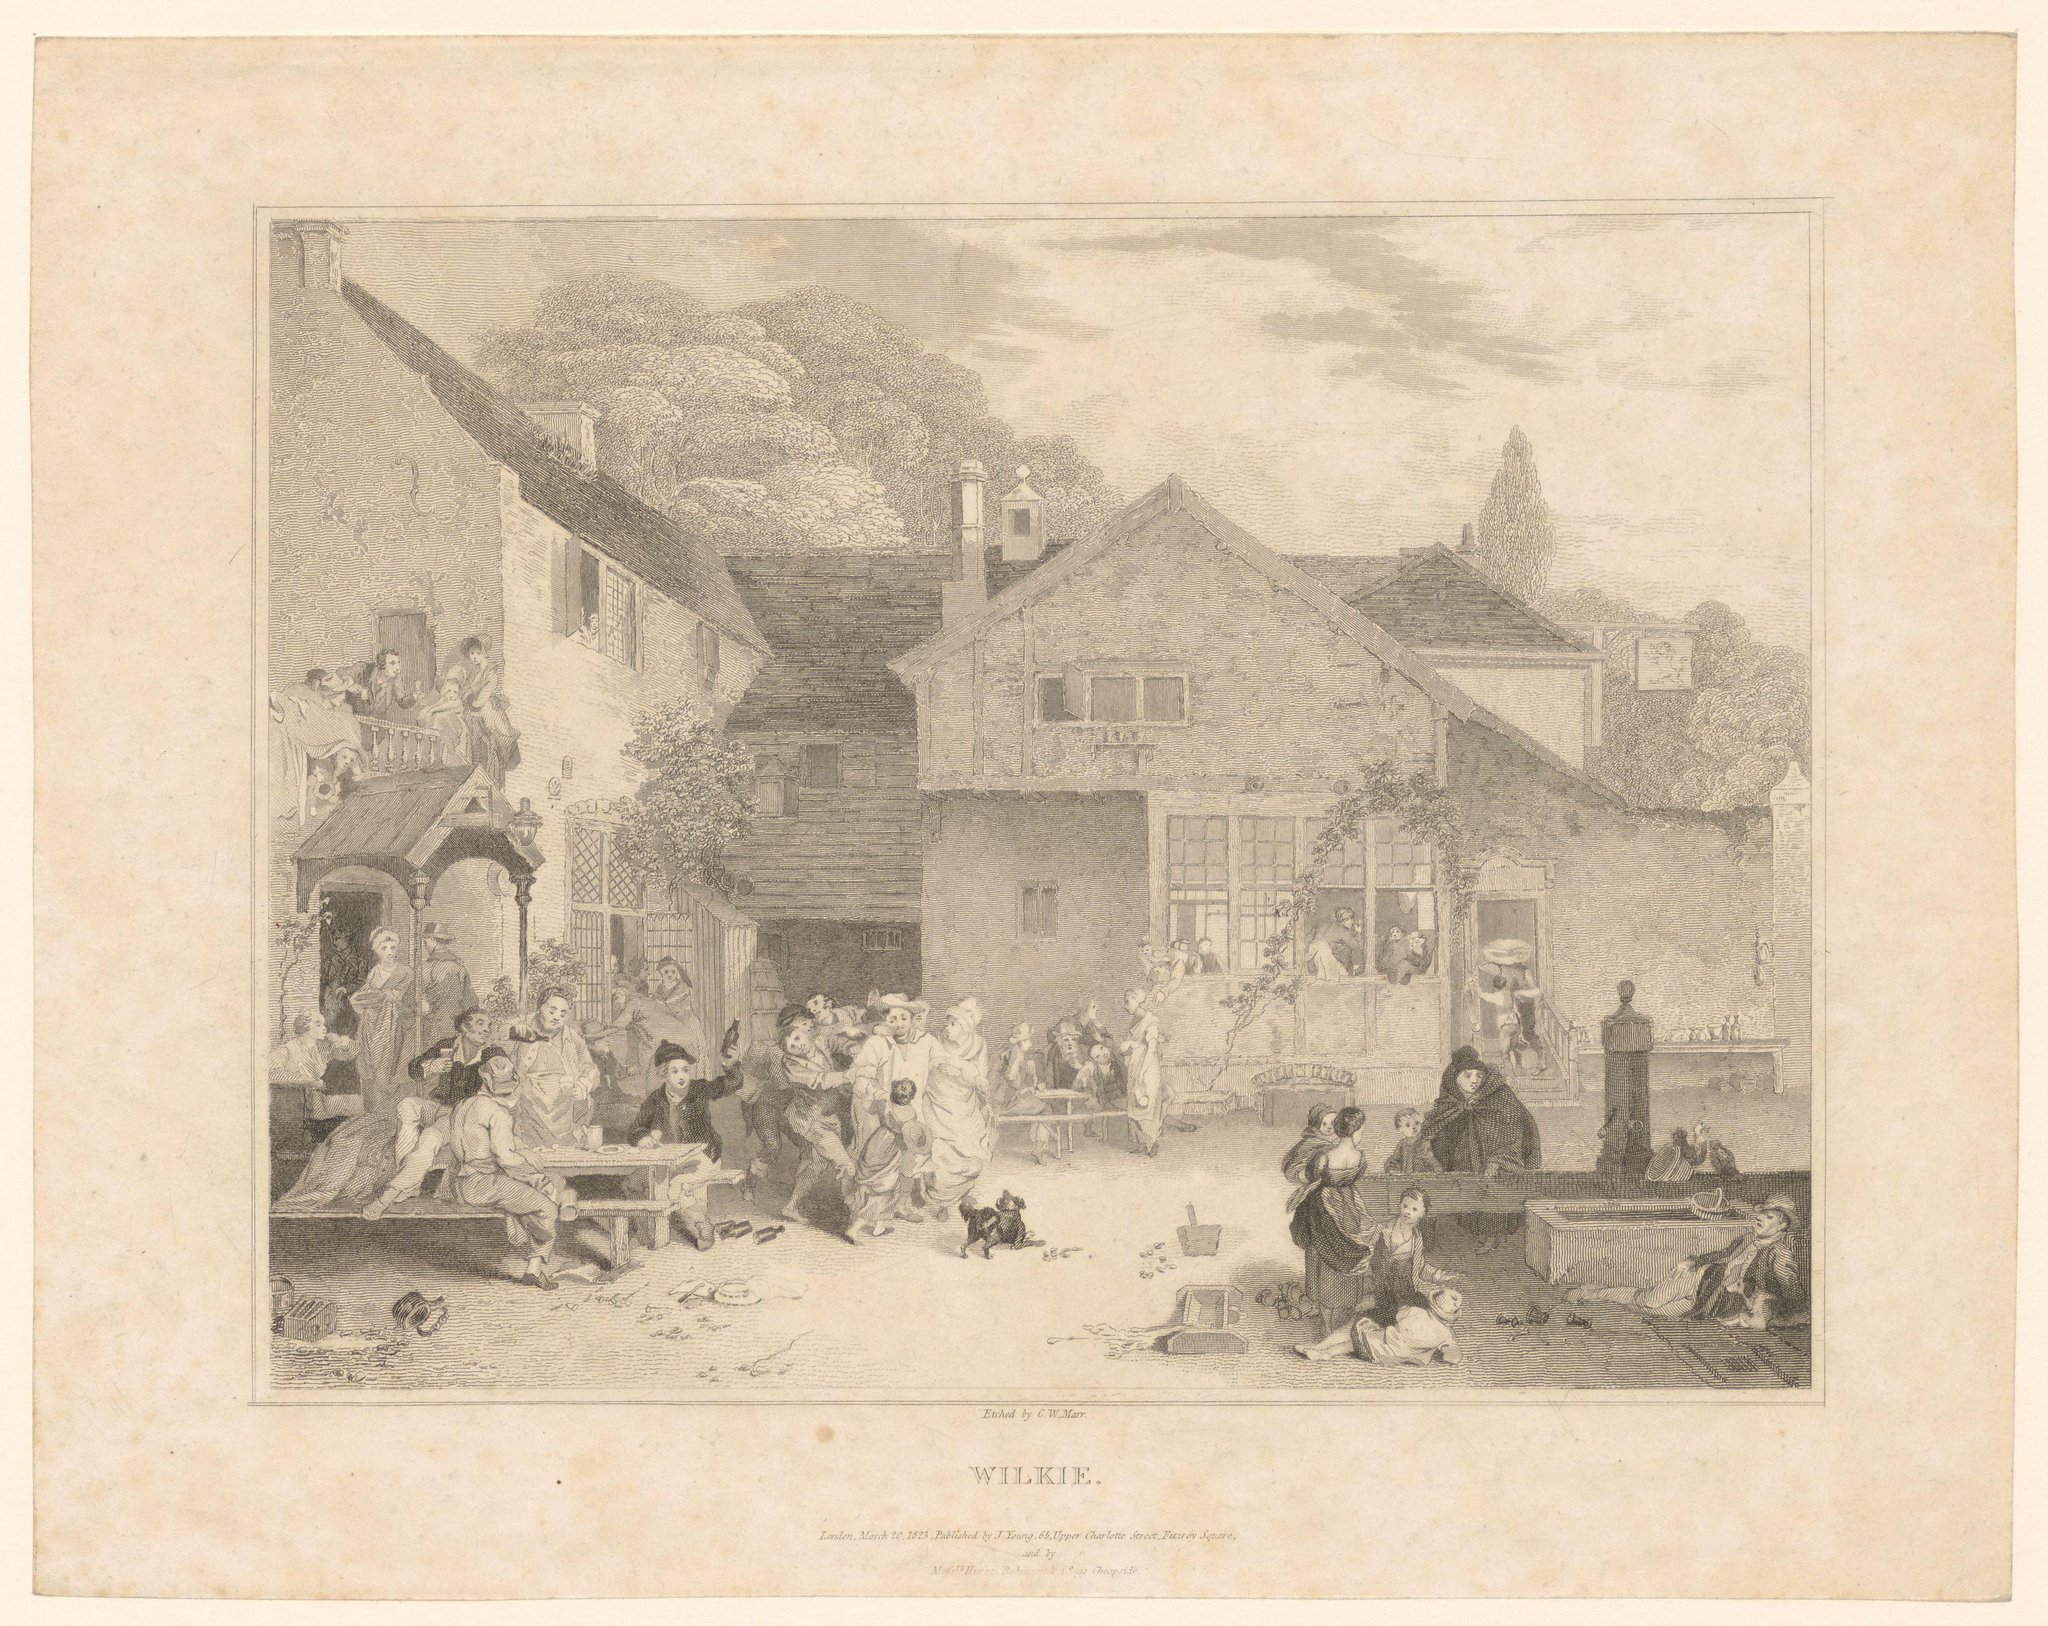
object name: print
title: Wilkie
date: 1823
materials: paper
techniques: etching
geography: london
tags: village (+ city(-scape) with figures, staffage), drunken brawl (usually peasants fighting in an inn)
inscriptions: collector's mark: Lugt 2228